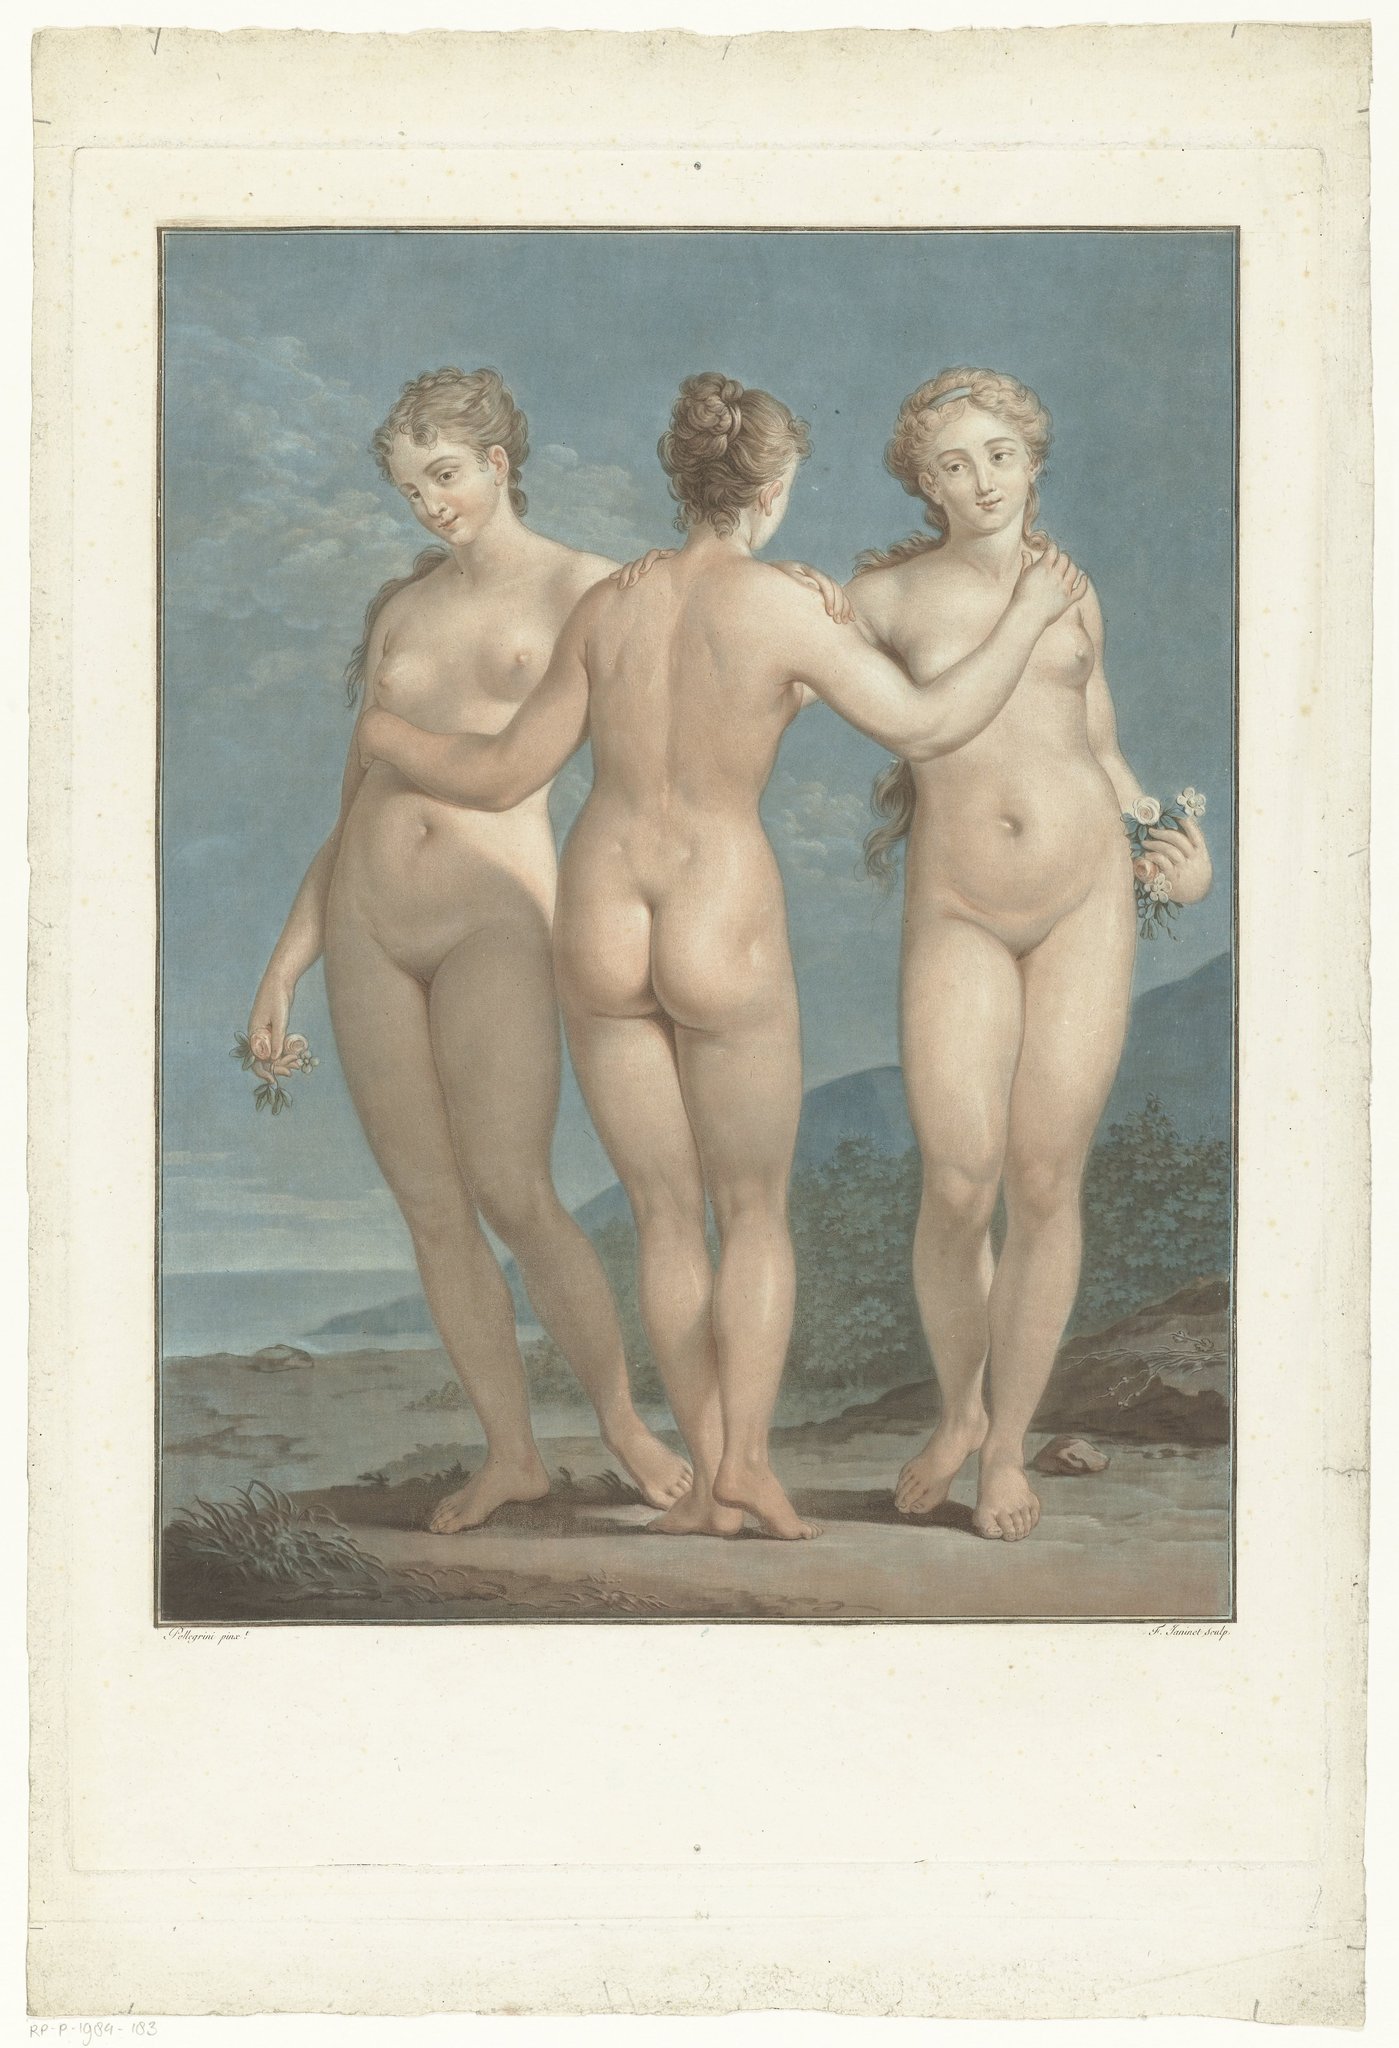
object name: print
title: Drie Gratiën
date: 1786-1787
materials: paper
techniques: color aquatint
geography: france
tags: graces (charites), generally three in number; 'gratie' (ripa)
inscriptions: collector's mark: Lugt 2228, collector's mark: Lugt 2760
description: De drie gratiën staand naakt in een landschap.